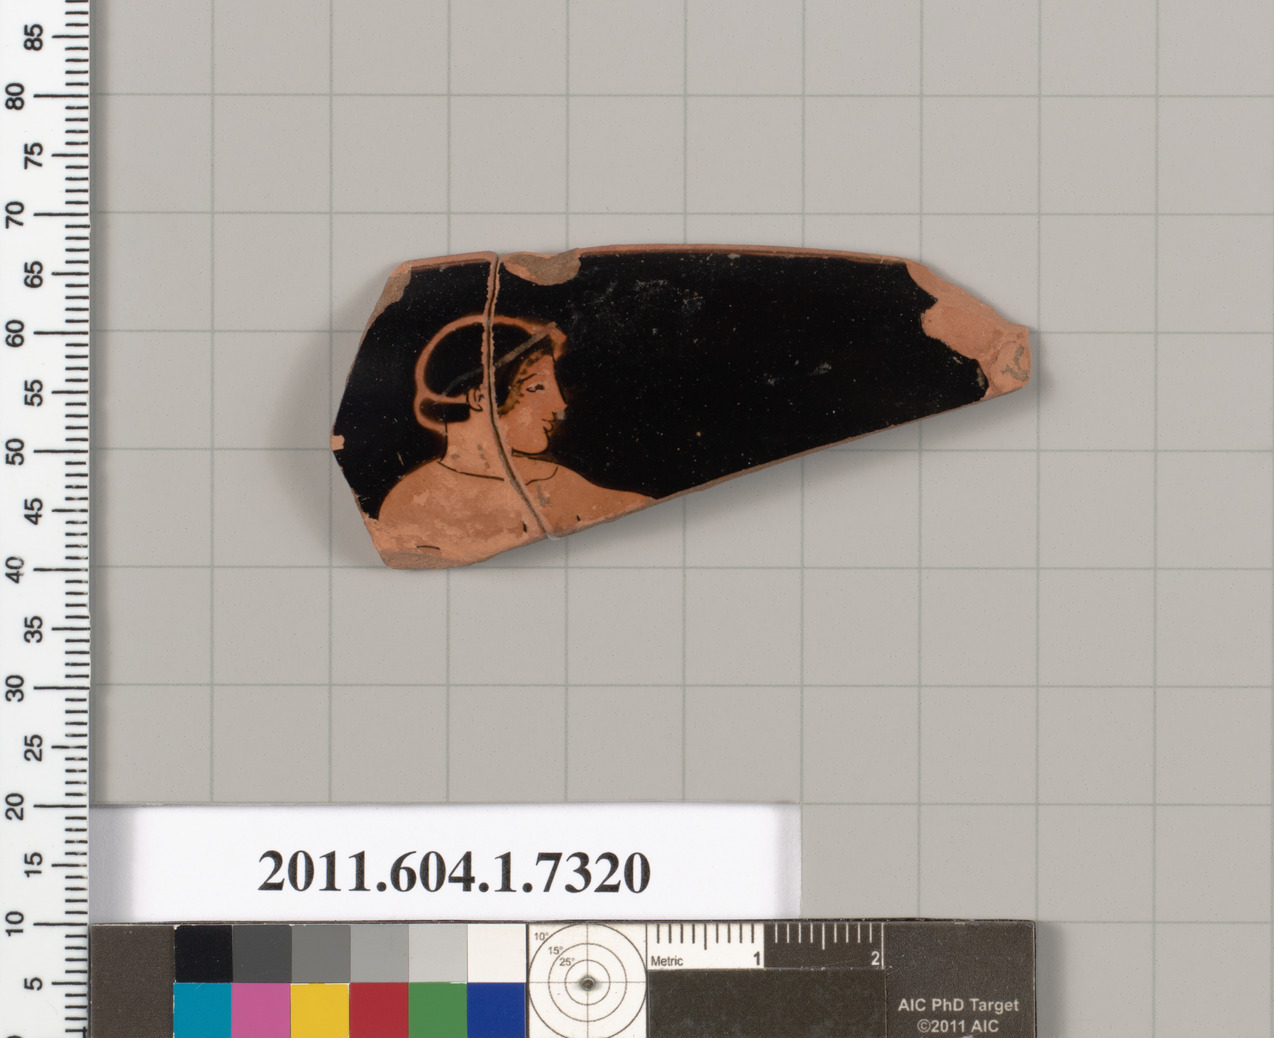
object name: kylix fragment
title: Terracotta rim fragment of a kylix (drinking cup)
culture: greek, attic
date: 500-480 BCE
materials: terracotta